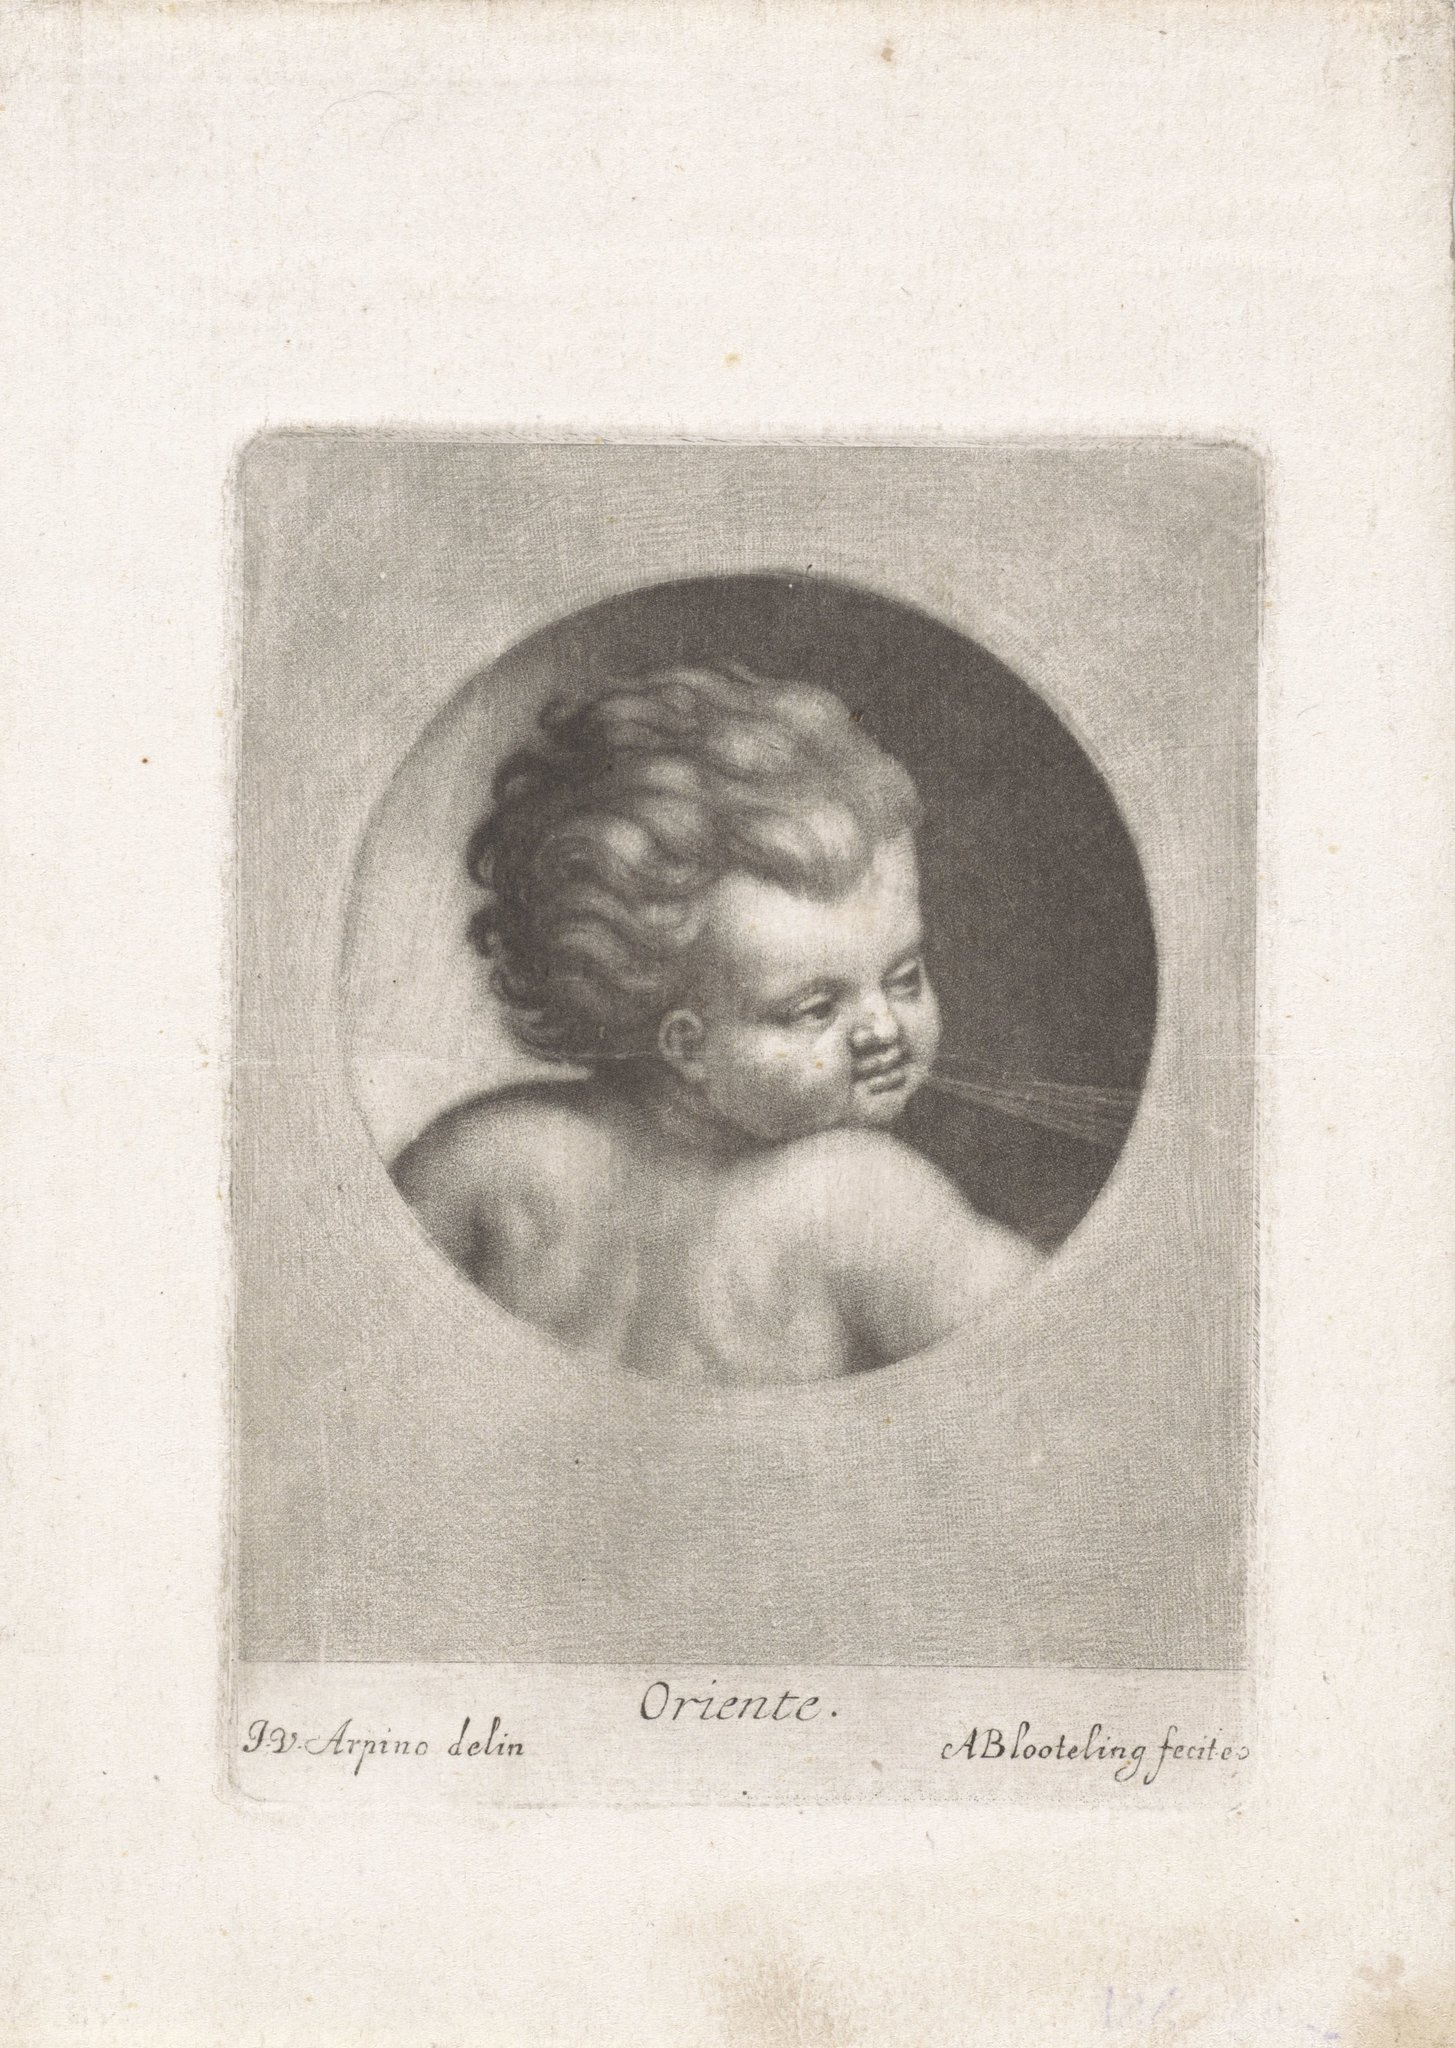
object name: print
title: Oriente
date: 1652-1690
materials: paper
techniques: engraving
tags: east wind (one of the four main directions)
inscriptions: collector's mark: Lugt 2228